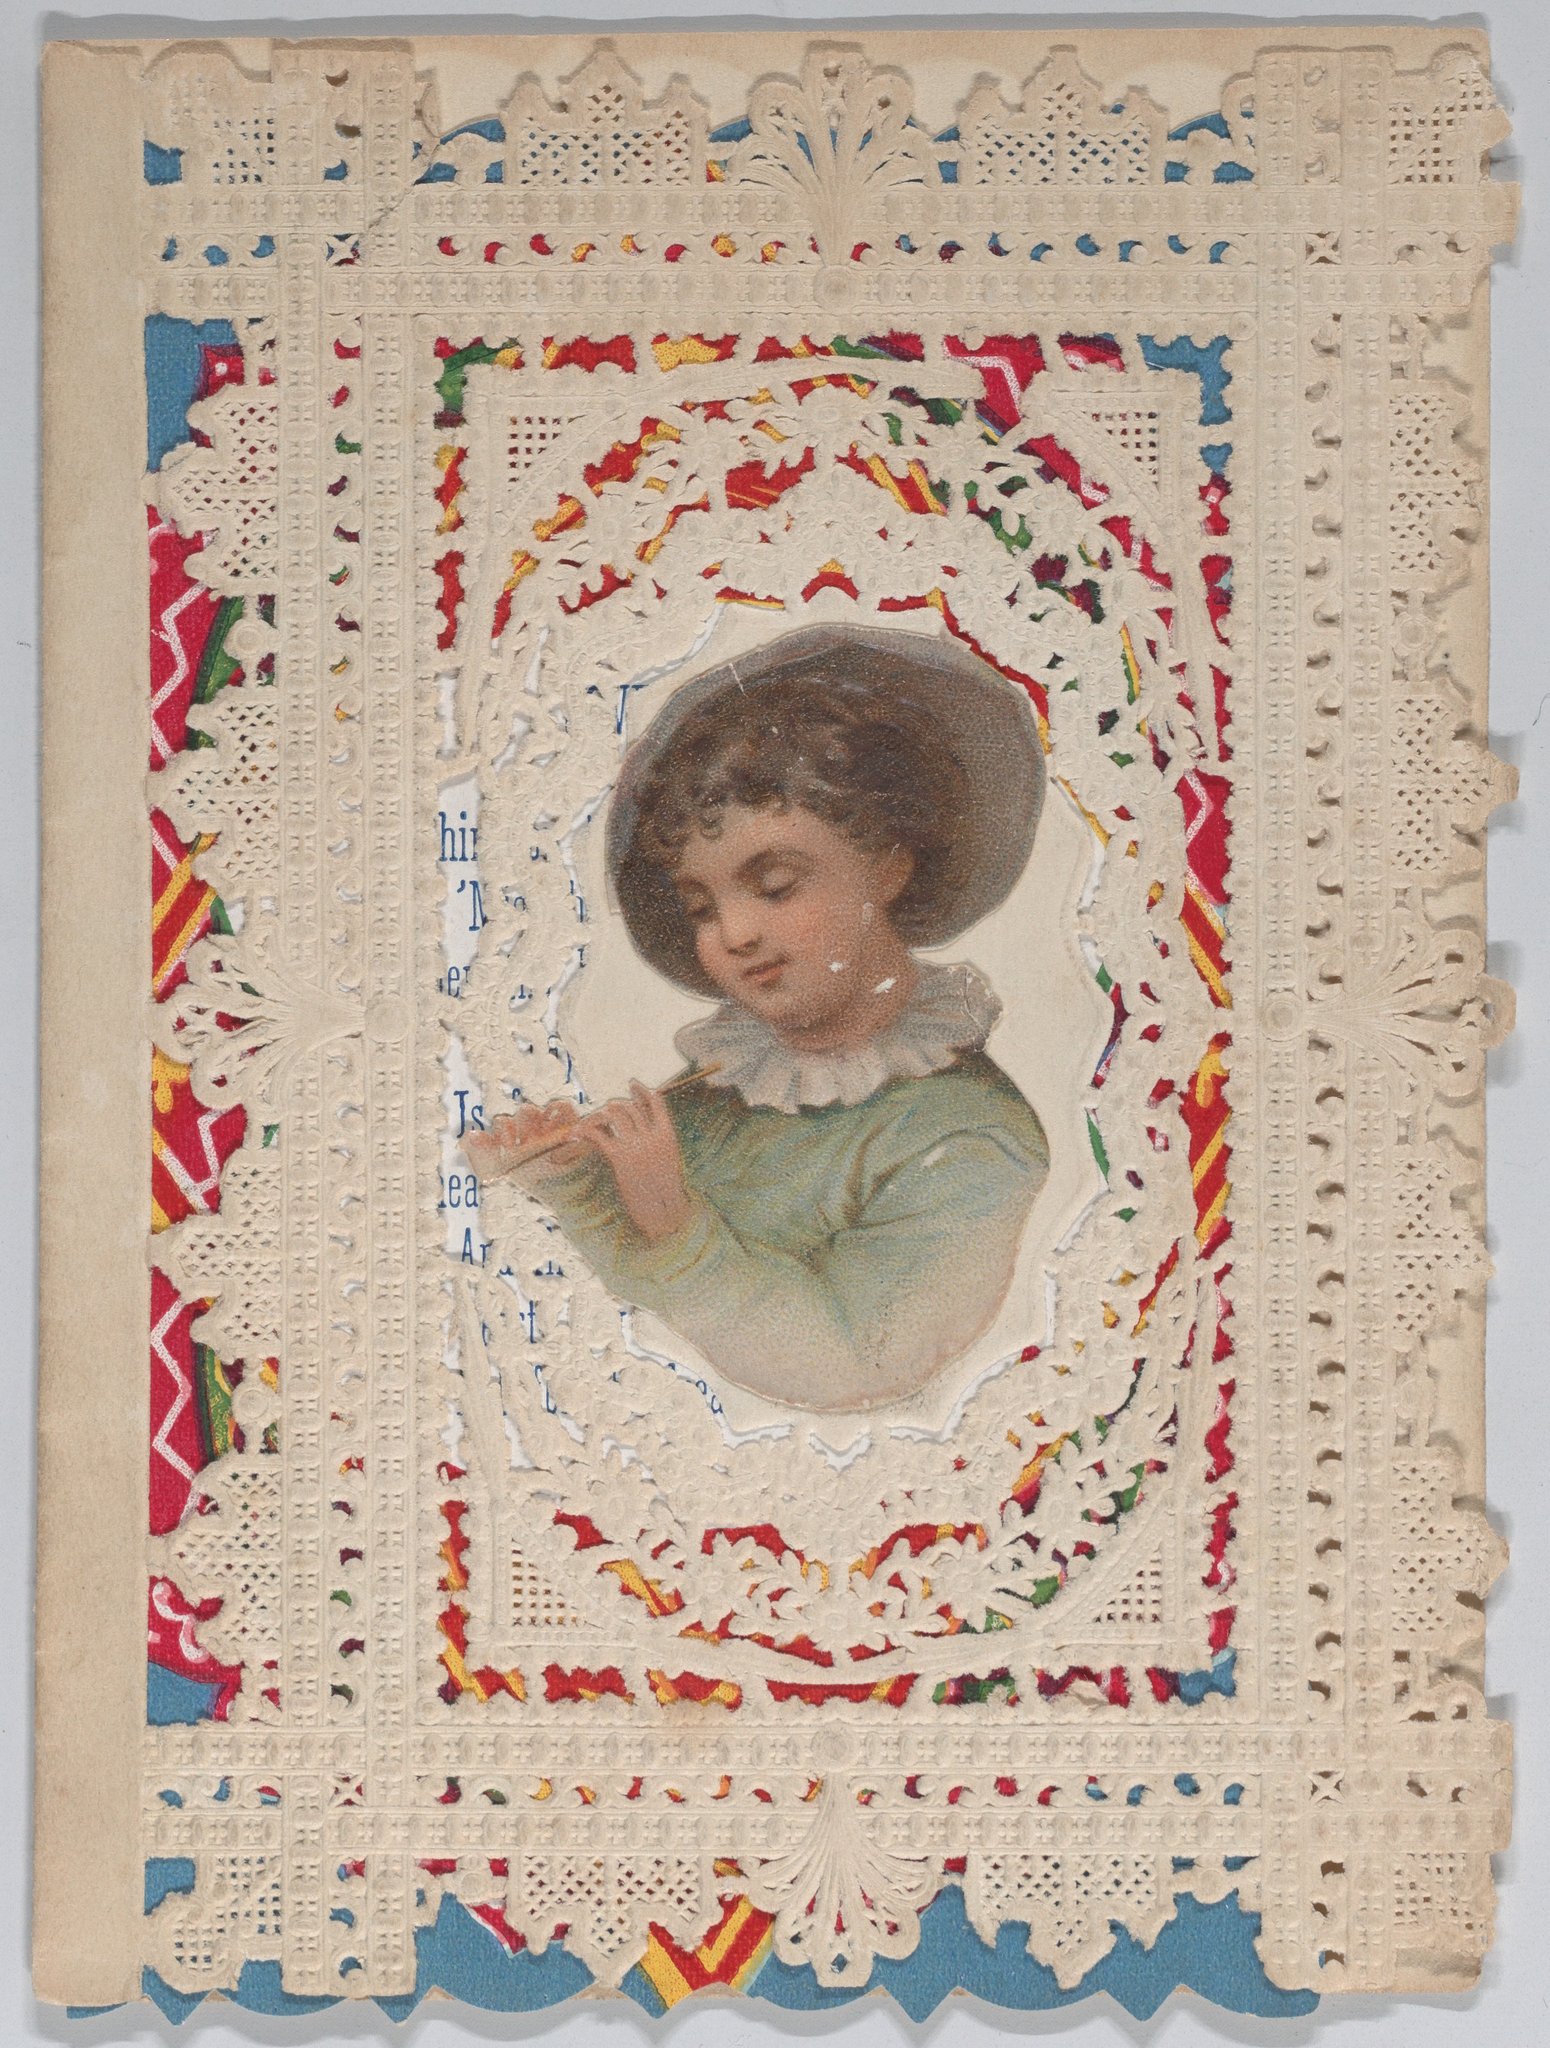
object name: valentine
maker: Anonymous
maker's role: artist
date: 1880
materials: lace, paper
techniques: chromolithography, embossing, open work